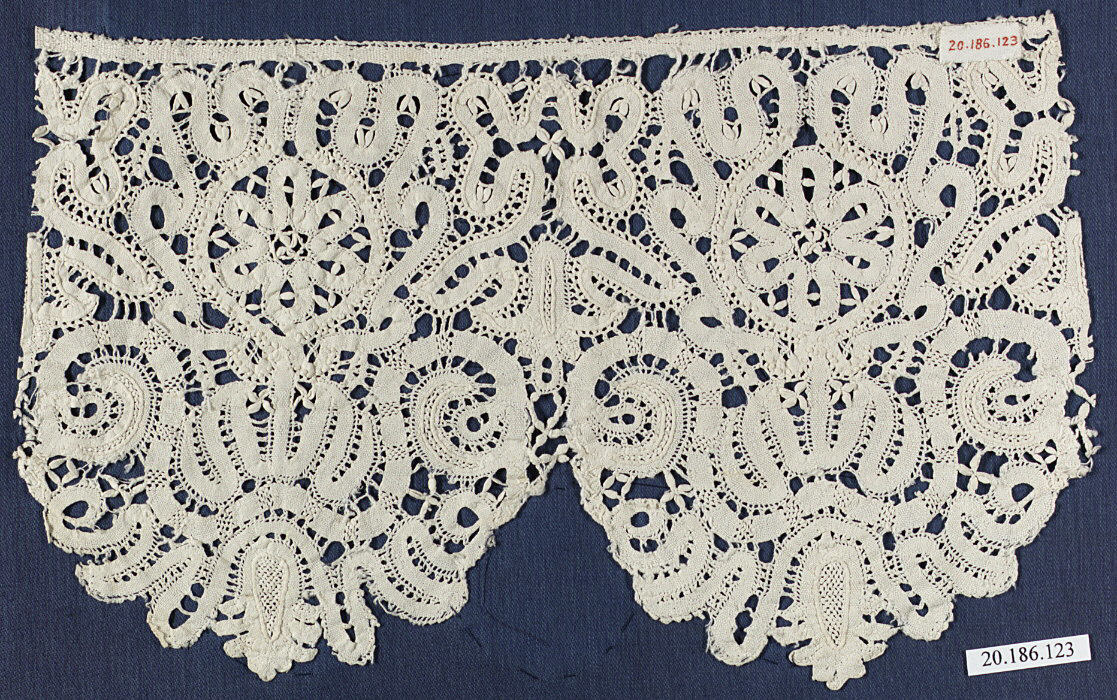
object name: fragment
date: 1601-1700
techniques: lace